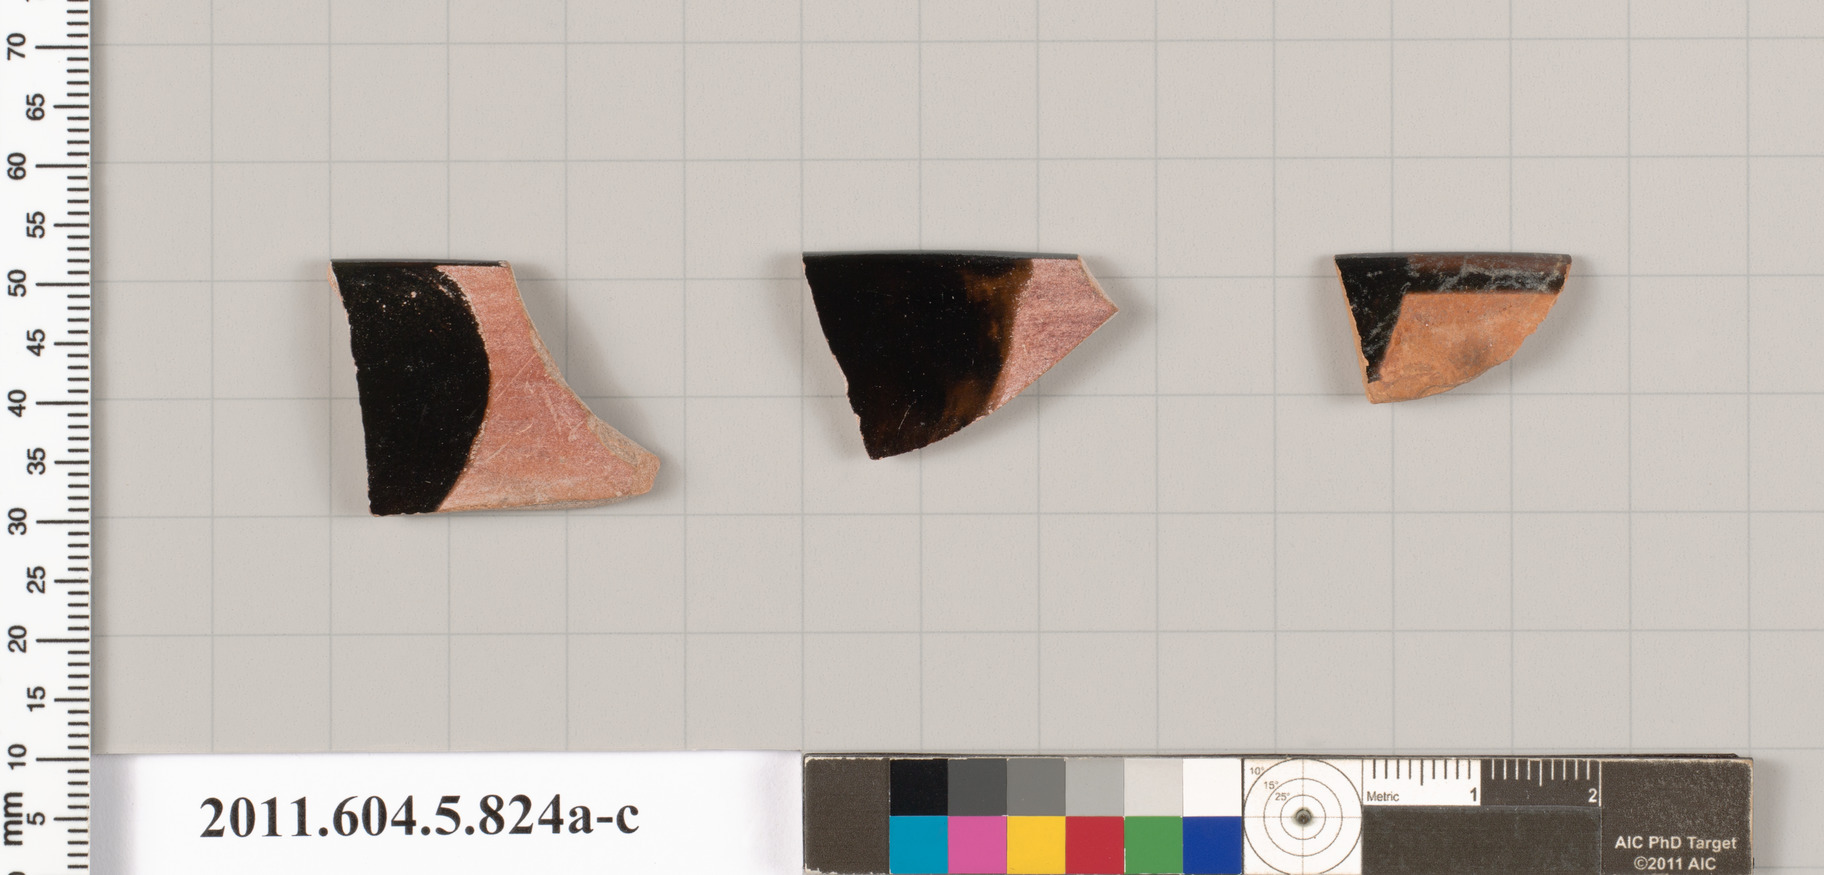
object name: kylix fragment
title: Terracotta rim fragments of kylikes (drinking cups)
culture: greek, attic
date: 600-401 BCE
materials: terracotta